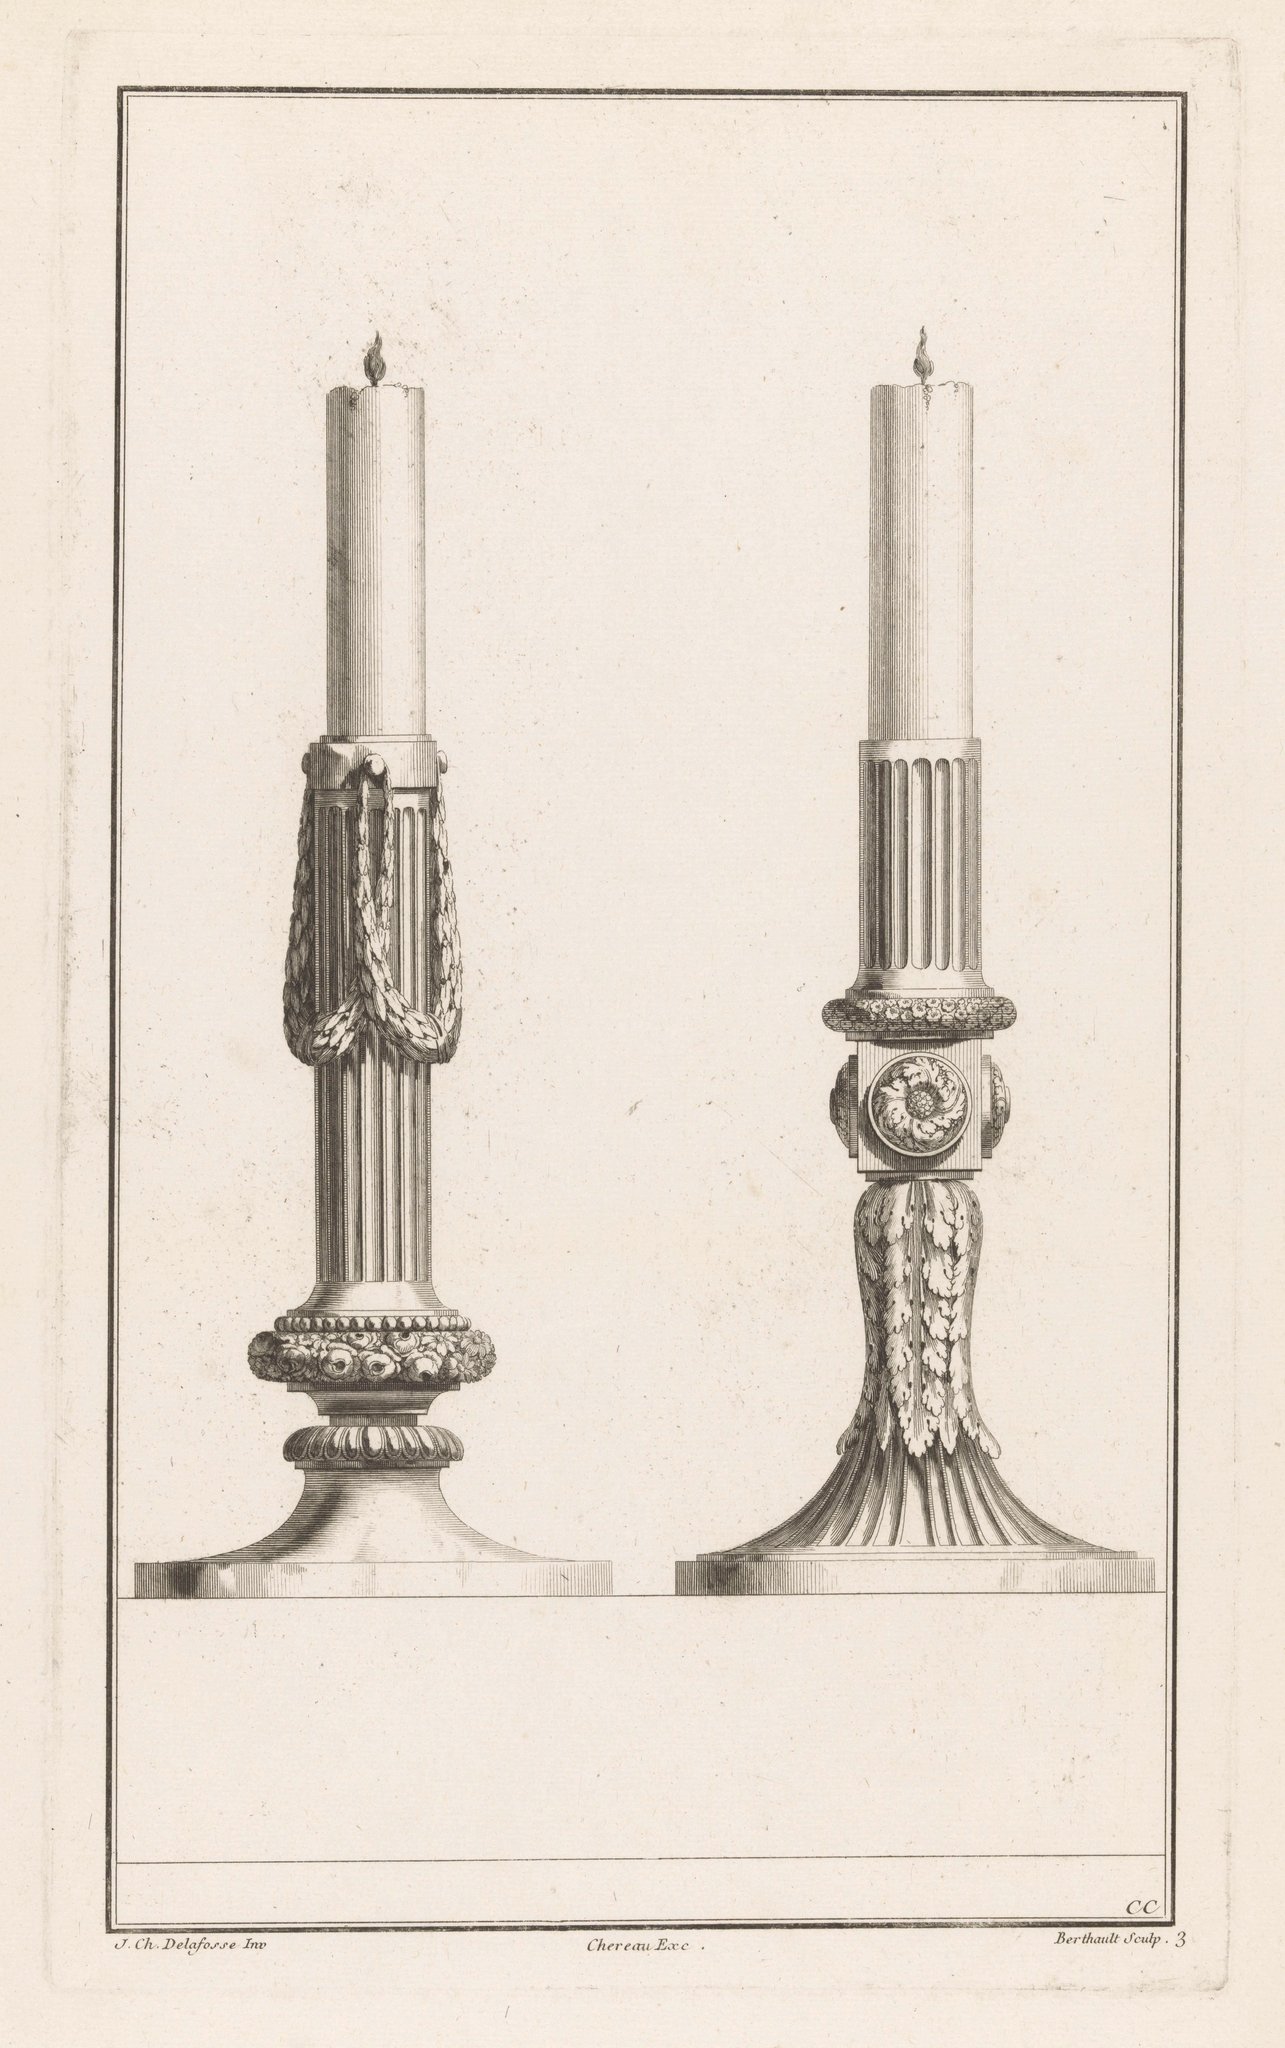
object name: print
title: 27e Cahier CC Cahier de 12 Flambeaux et Chandeliers de Table &c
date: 1771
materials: paper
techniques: engraving, etching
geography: paris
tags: chandelier, candelabrum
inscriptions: collector's mark: Lugt 2760, collector's mark: Lugt 2228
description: Twee kandelaars, links met guirlandes en rechts met bladmotieven.